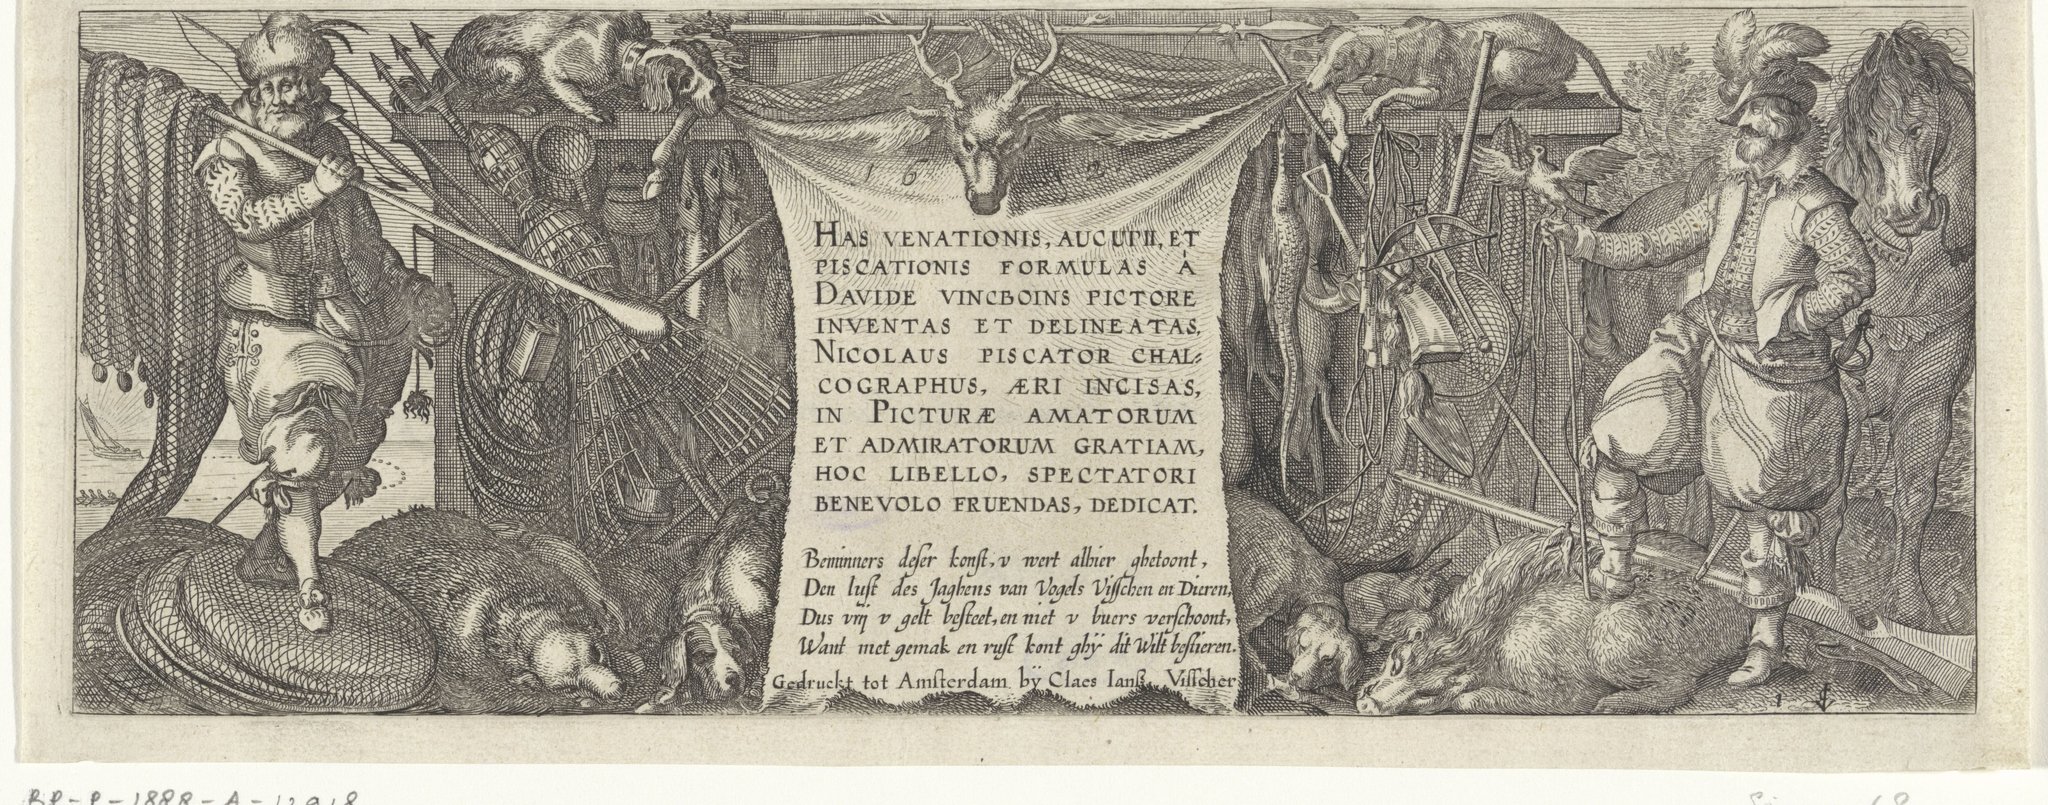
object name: titelprent, frontispice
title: Jachten op vogels, vissen en zoogdieren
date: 1612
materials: paper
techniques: engraving, etching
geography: amsterdam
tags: hunting, chase, hunter, title-page, fowling, fowler, fisherman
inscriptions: number: ‘1’, inscription: ‘HAS VENATIONIS, AUCUPII, ET PISCATIONIS FORMULAS A DAVIDE VINCBOINS....’, collector's mark: Lugt 2228, address: ‘Gedruckt tot Amsterdam bij Claes Jansz. Visscher.’, date: ‘1612’, caption: ‘Beminners dezer konst, u wert alhier ghetoont, Den lust des Jaghens van Vogels, Visschen en Dieren, Dus vrij gelt besteet, en niet u beurs verschoont, Want met gemak en rust kont ghij wit Wilt bestieren.’, monogram: ‘CIV’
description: Titelprent: In het midden, op een dierenvel, jaar van uitgave (1612) de titel en, onderaan, het adres van Claes Jansz. Visscher. Bovenaan een hertenkop. Rechts staat een jager met een lijmvogel in de hand, zijn voet rustend op een geschoten beer. Hij is omgeven door jachtattributenen trofeeën. Achter hem een paard. Links staat een visser met netten aan een stok over zijn schouder, omgeven door vissersgereedschap.